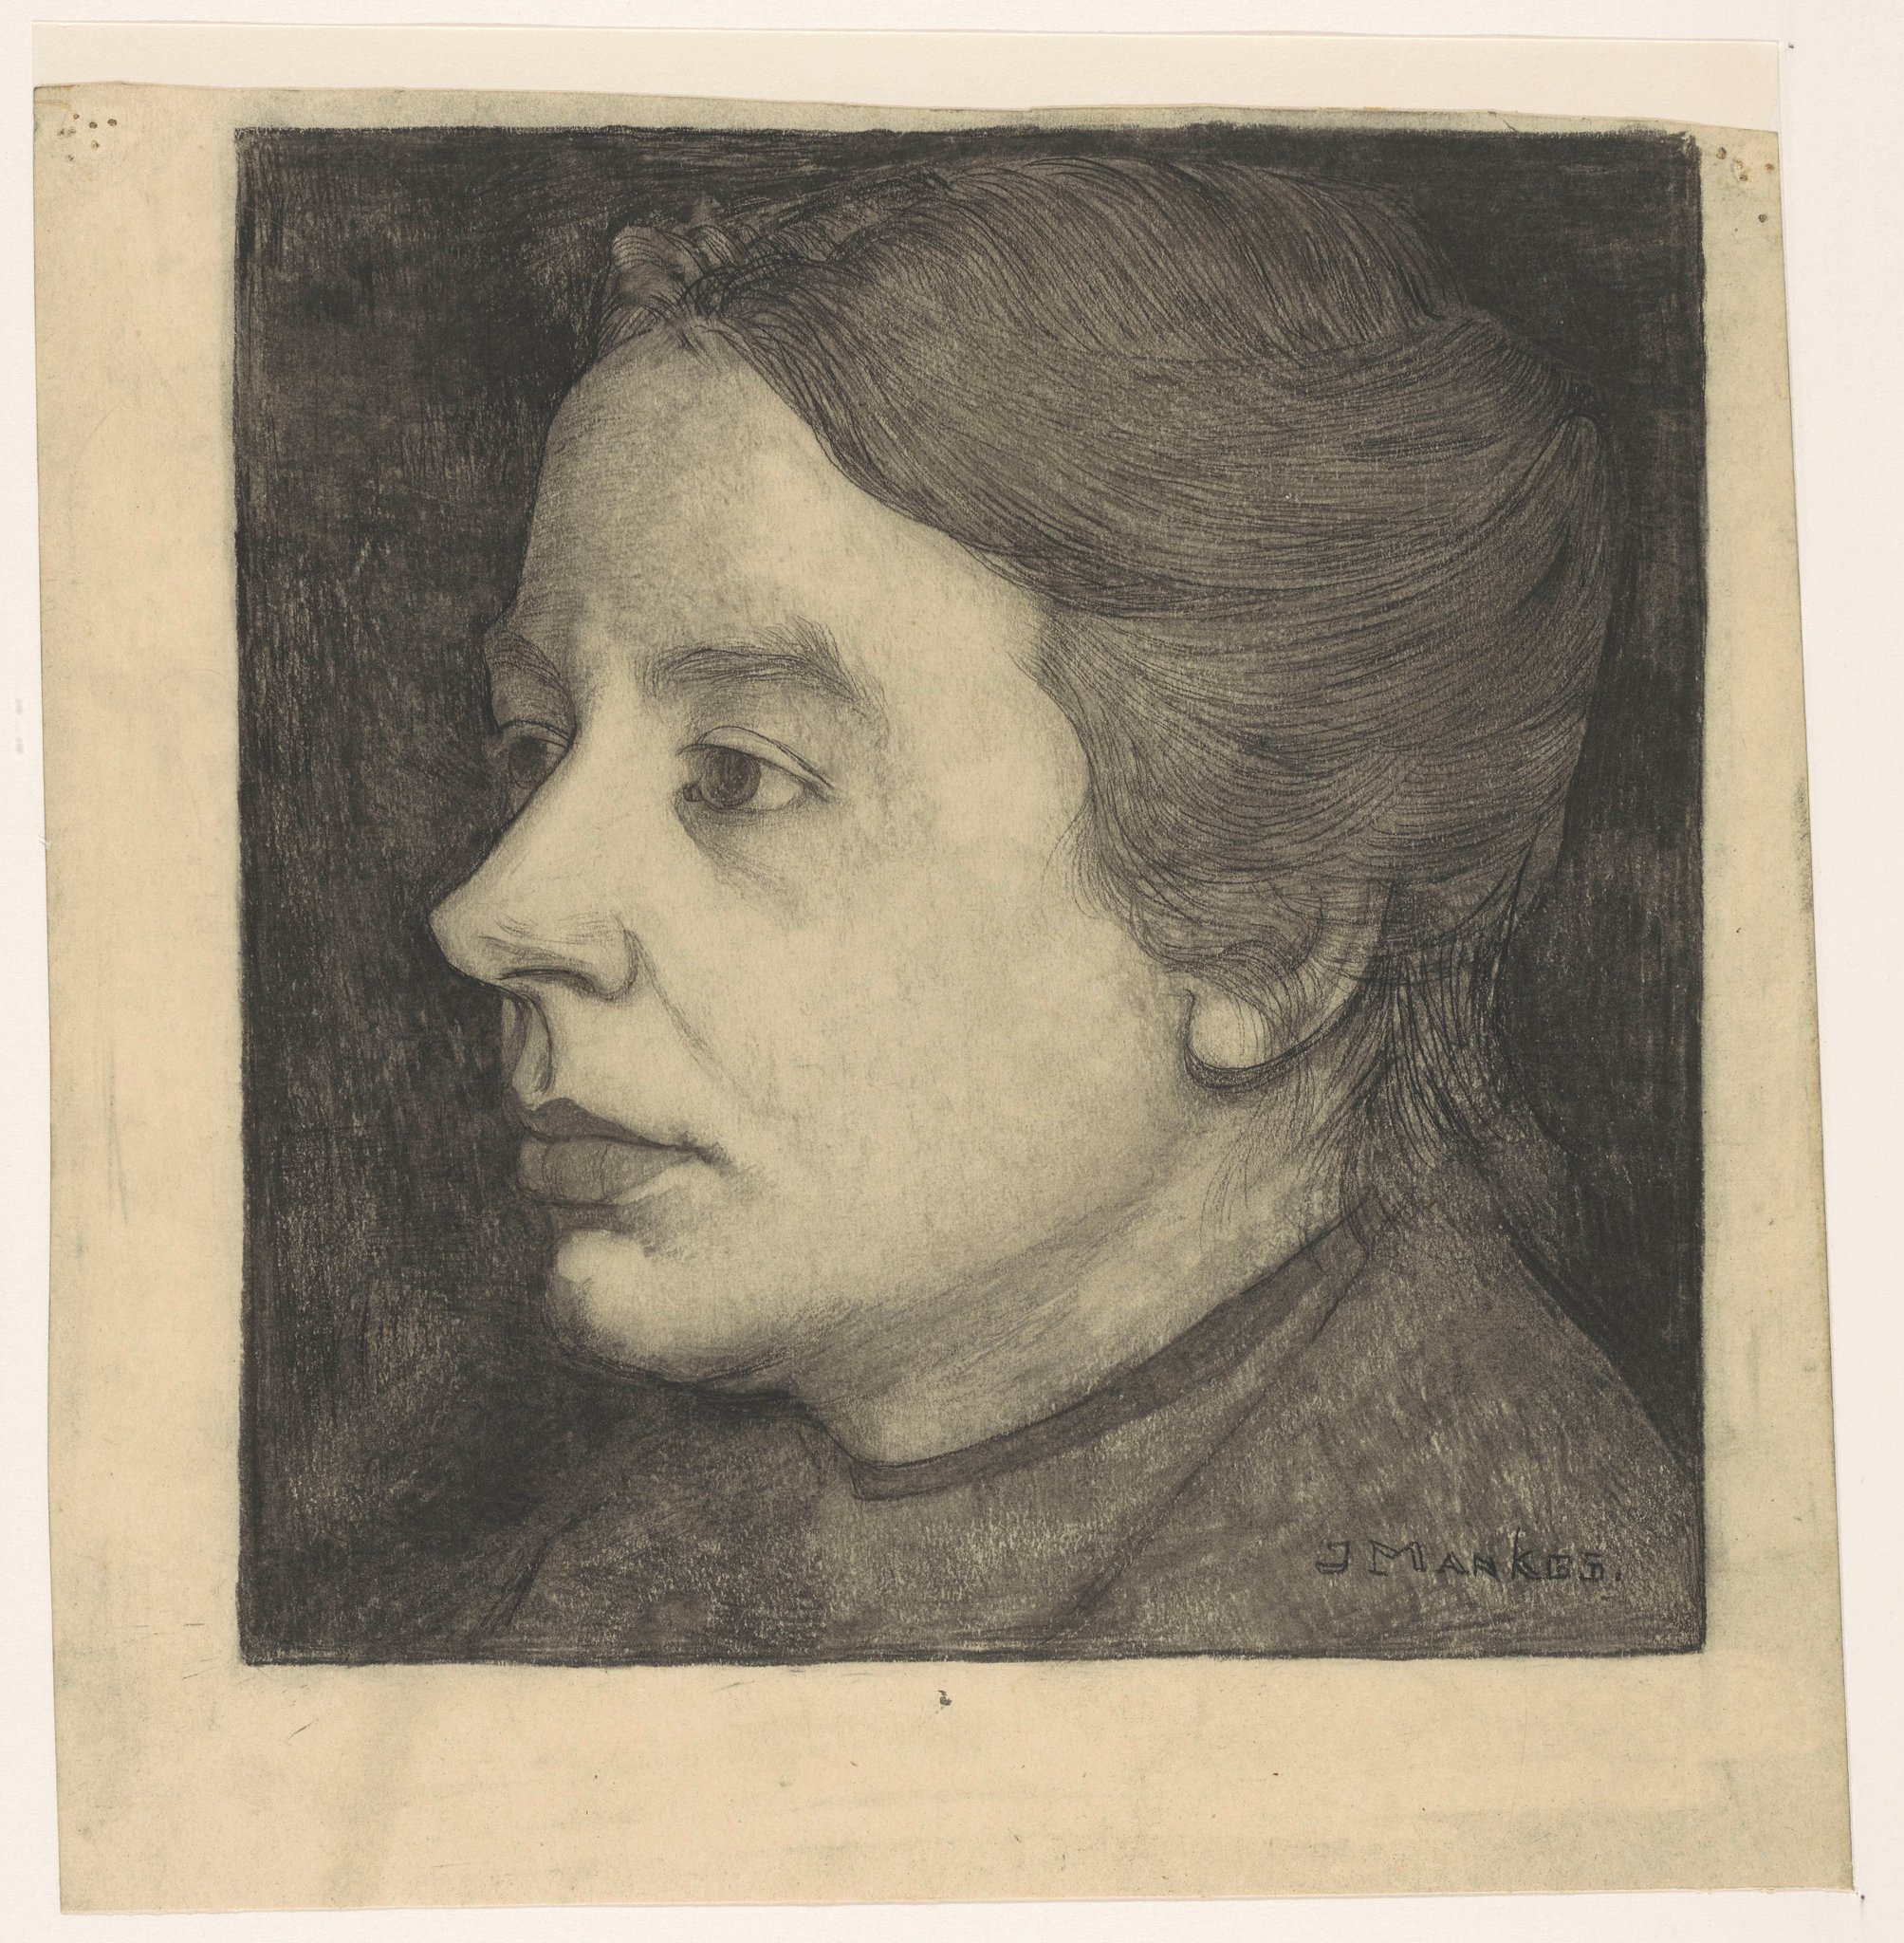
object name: drawing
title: Portret van Anne Mankes-Zernike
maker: jan mankes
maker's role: draughtsman, painter, print maker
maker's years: 1889-1920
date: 1899-1920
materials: chalk, charcoal, paper, pencil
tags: amsterdam, anne mankes-zernike, historical persons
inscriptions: collector's mark: Lugt 2228